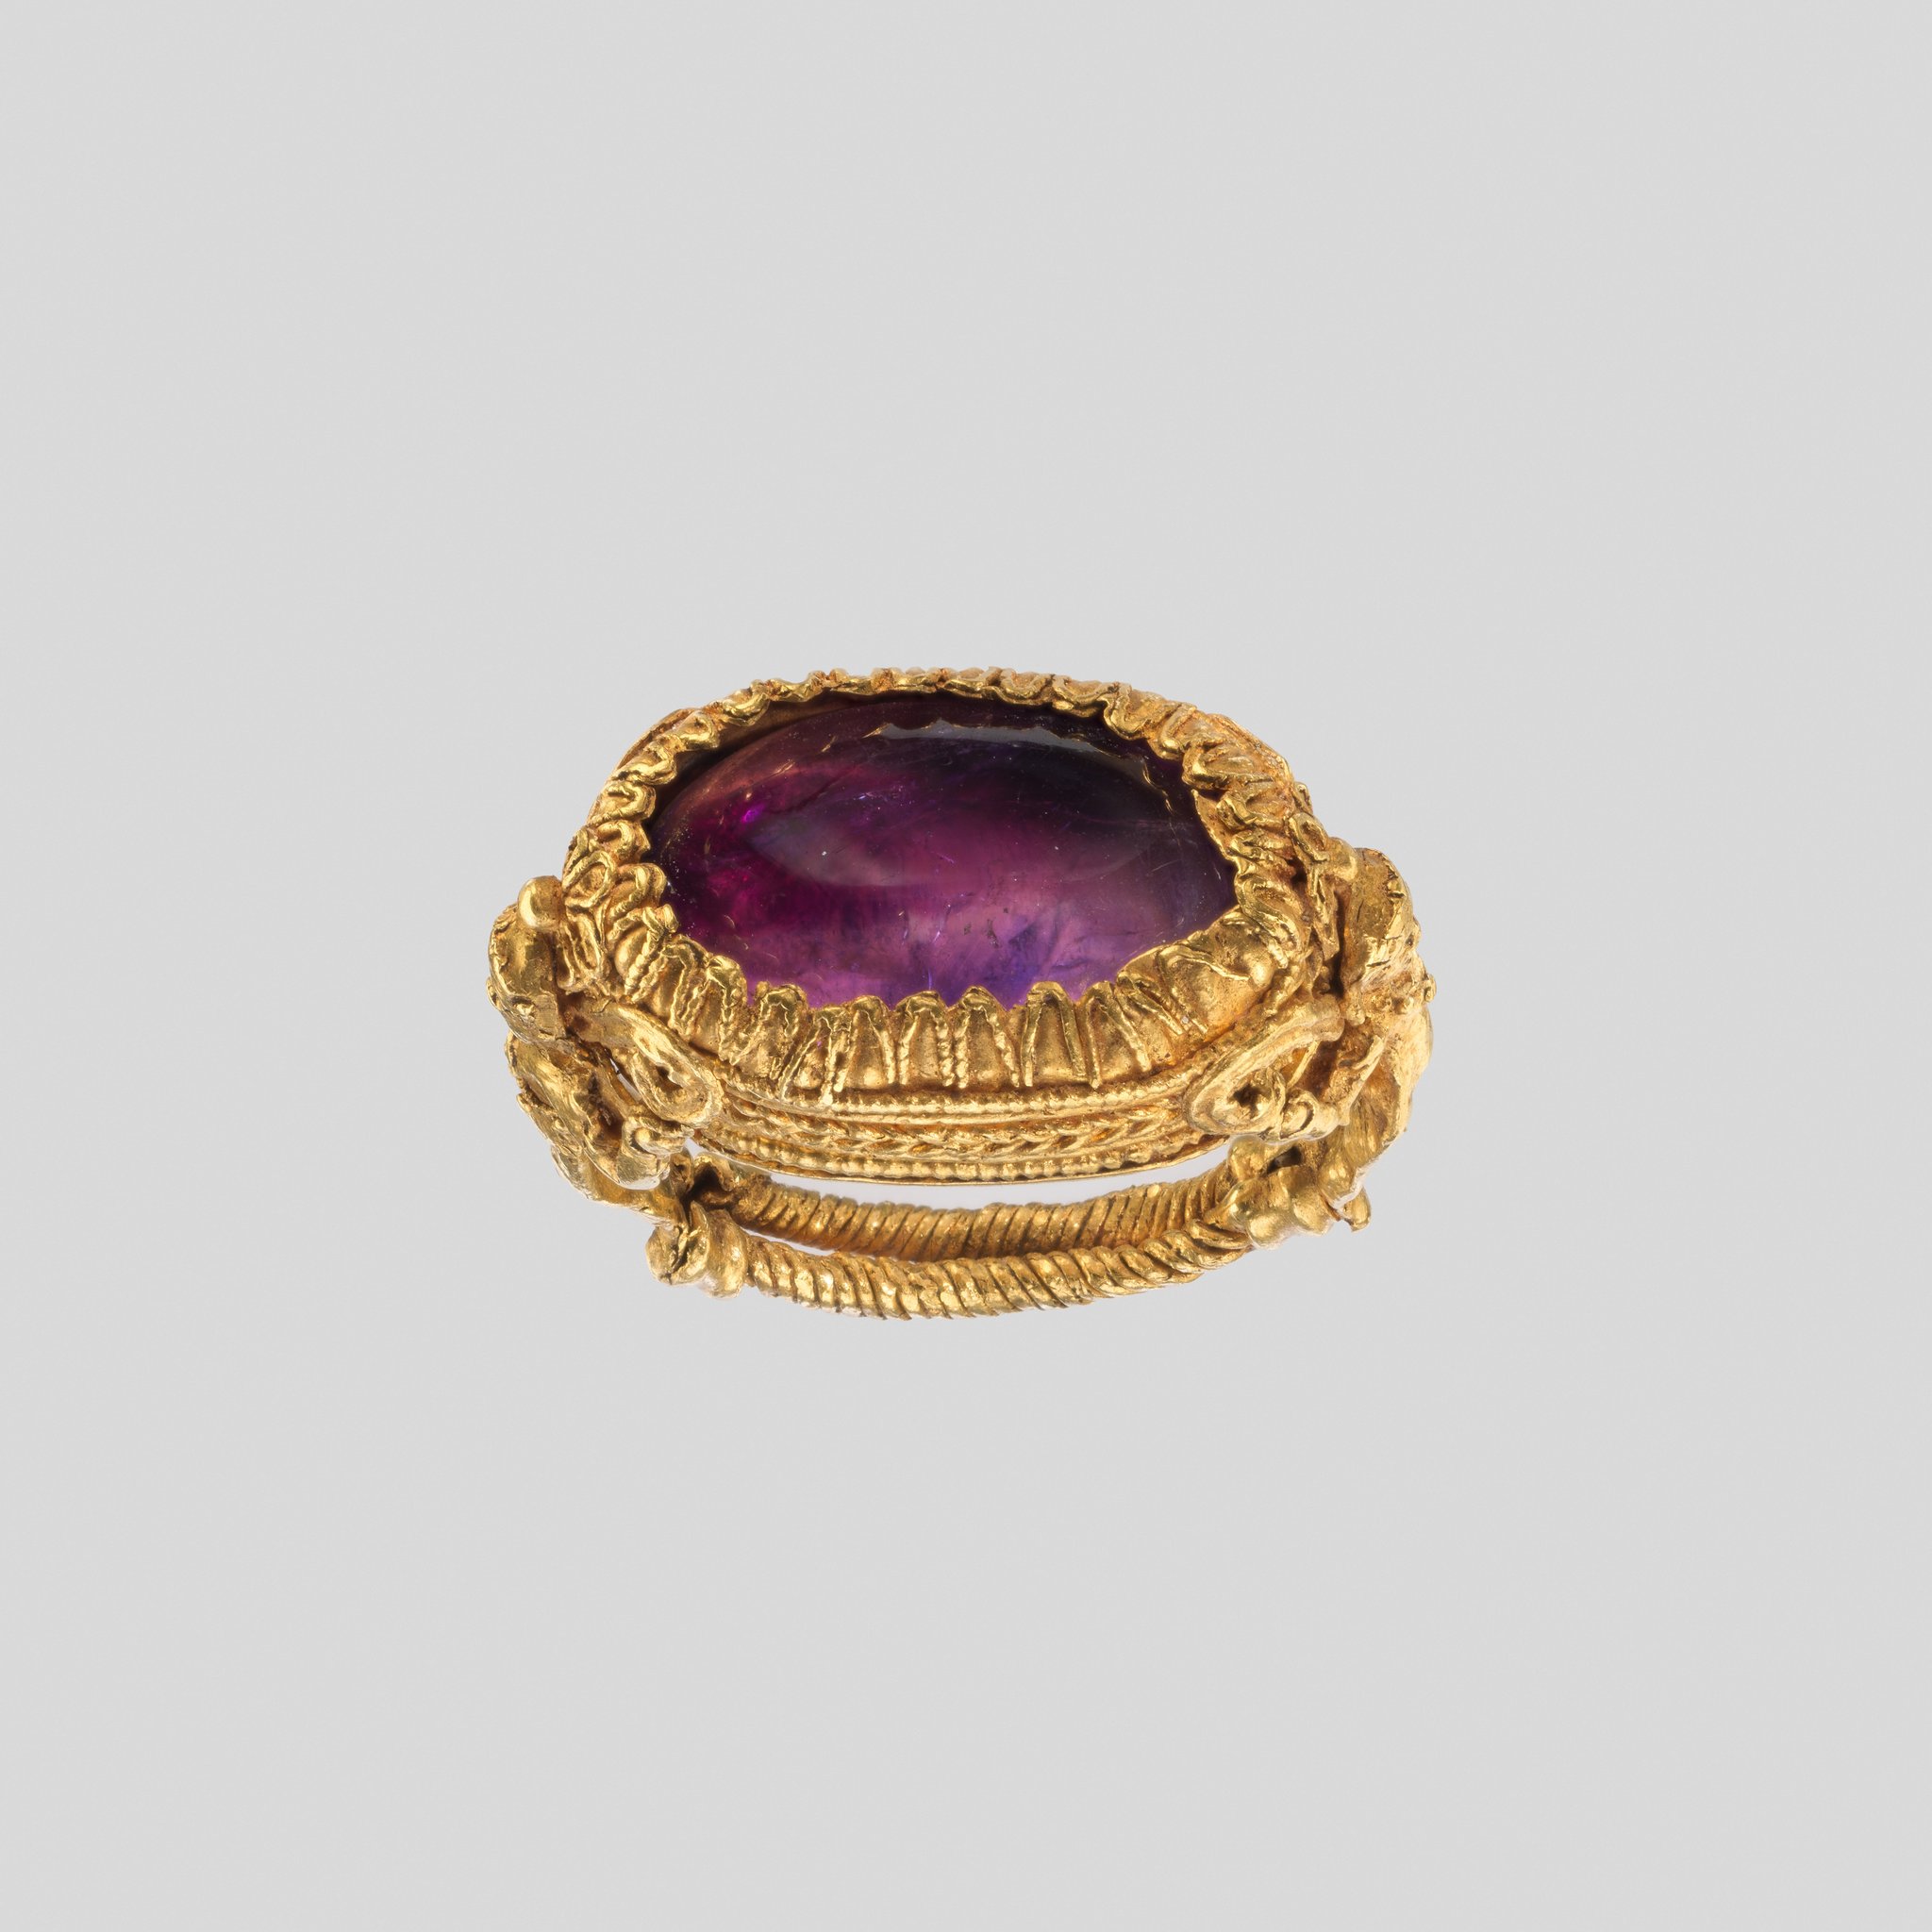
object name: ring, figure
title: Gold and amethyst ring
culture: greek, cypriot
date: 300-101 BCE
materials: gemstone, gold